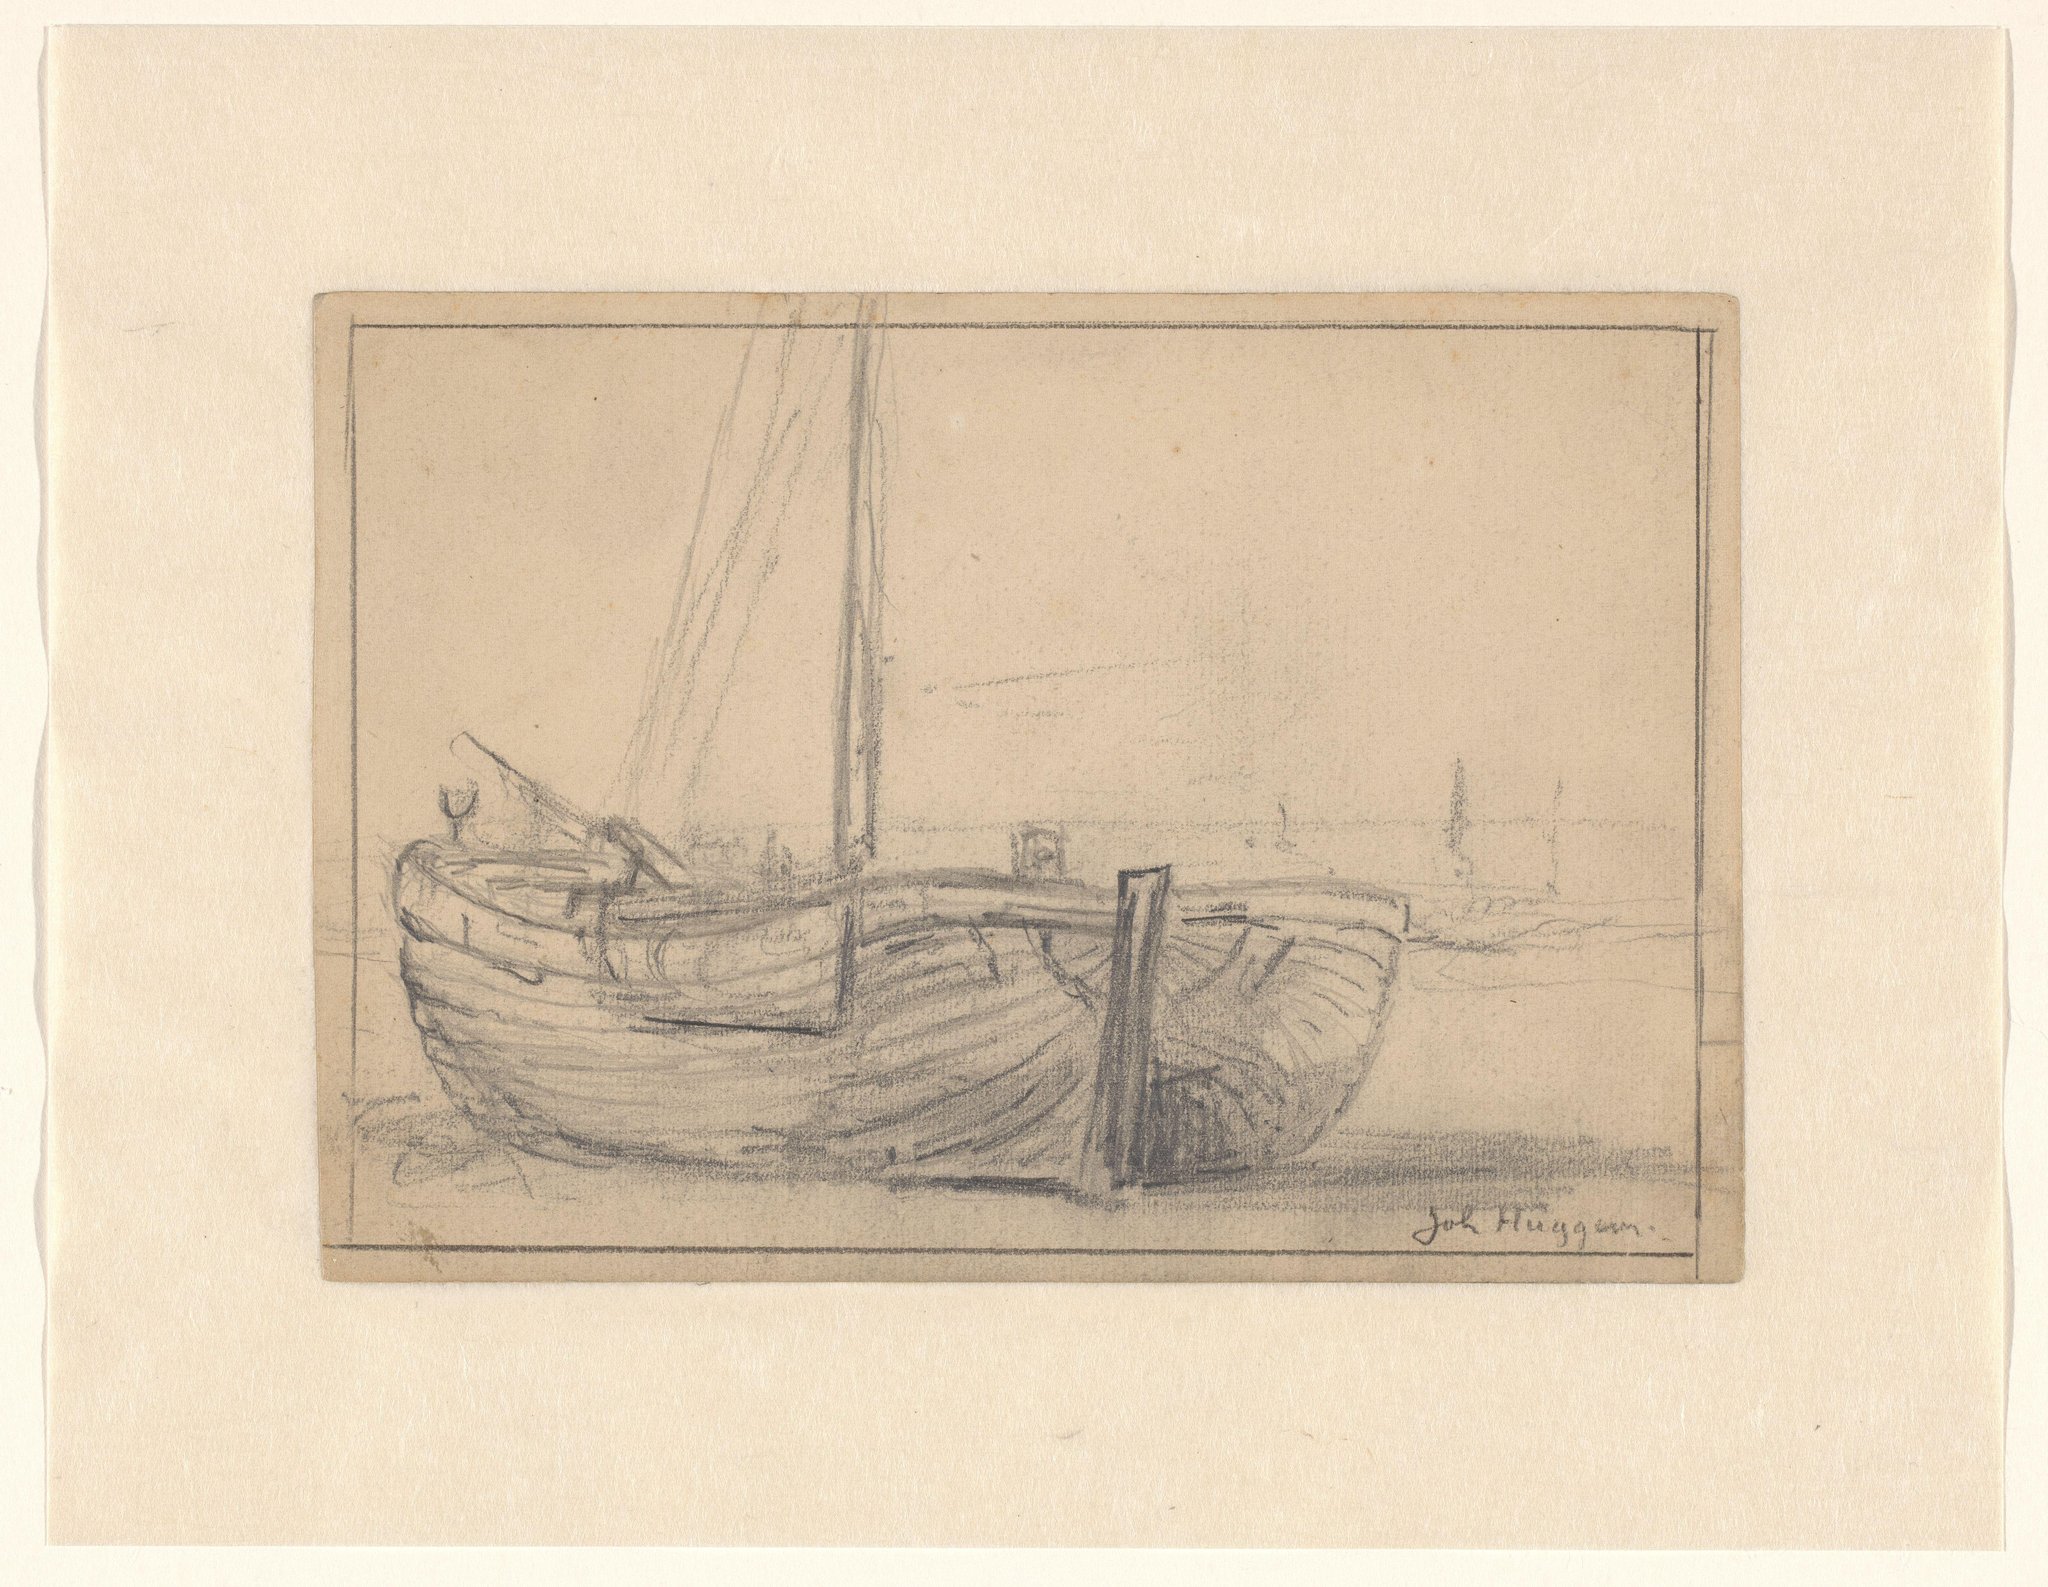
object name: drawing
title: Bomschuit op het strand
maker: johannes huygens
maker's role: draughtsman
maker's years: 1833-1911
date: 1843-1911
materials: chalk, paper, pencil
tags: sailing-ship, sailing-boat